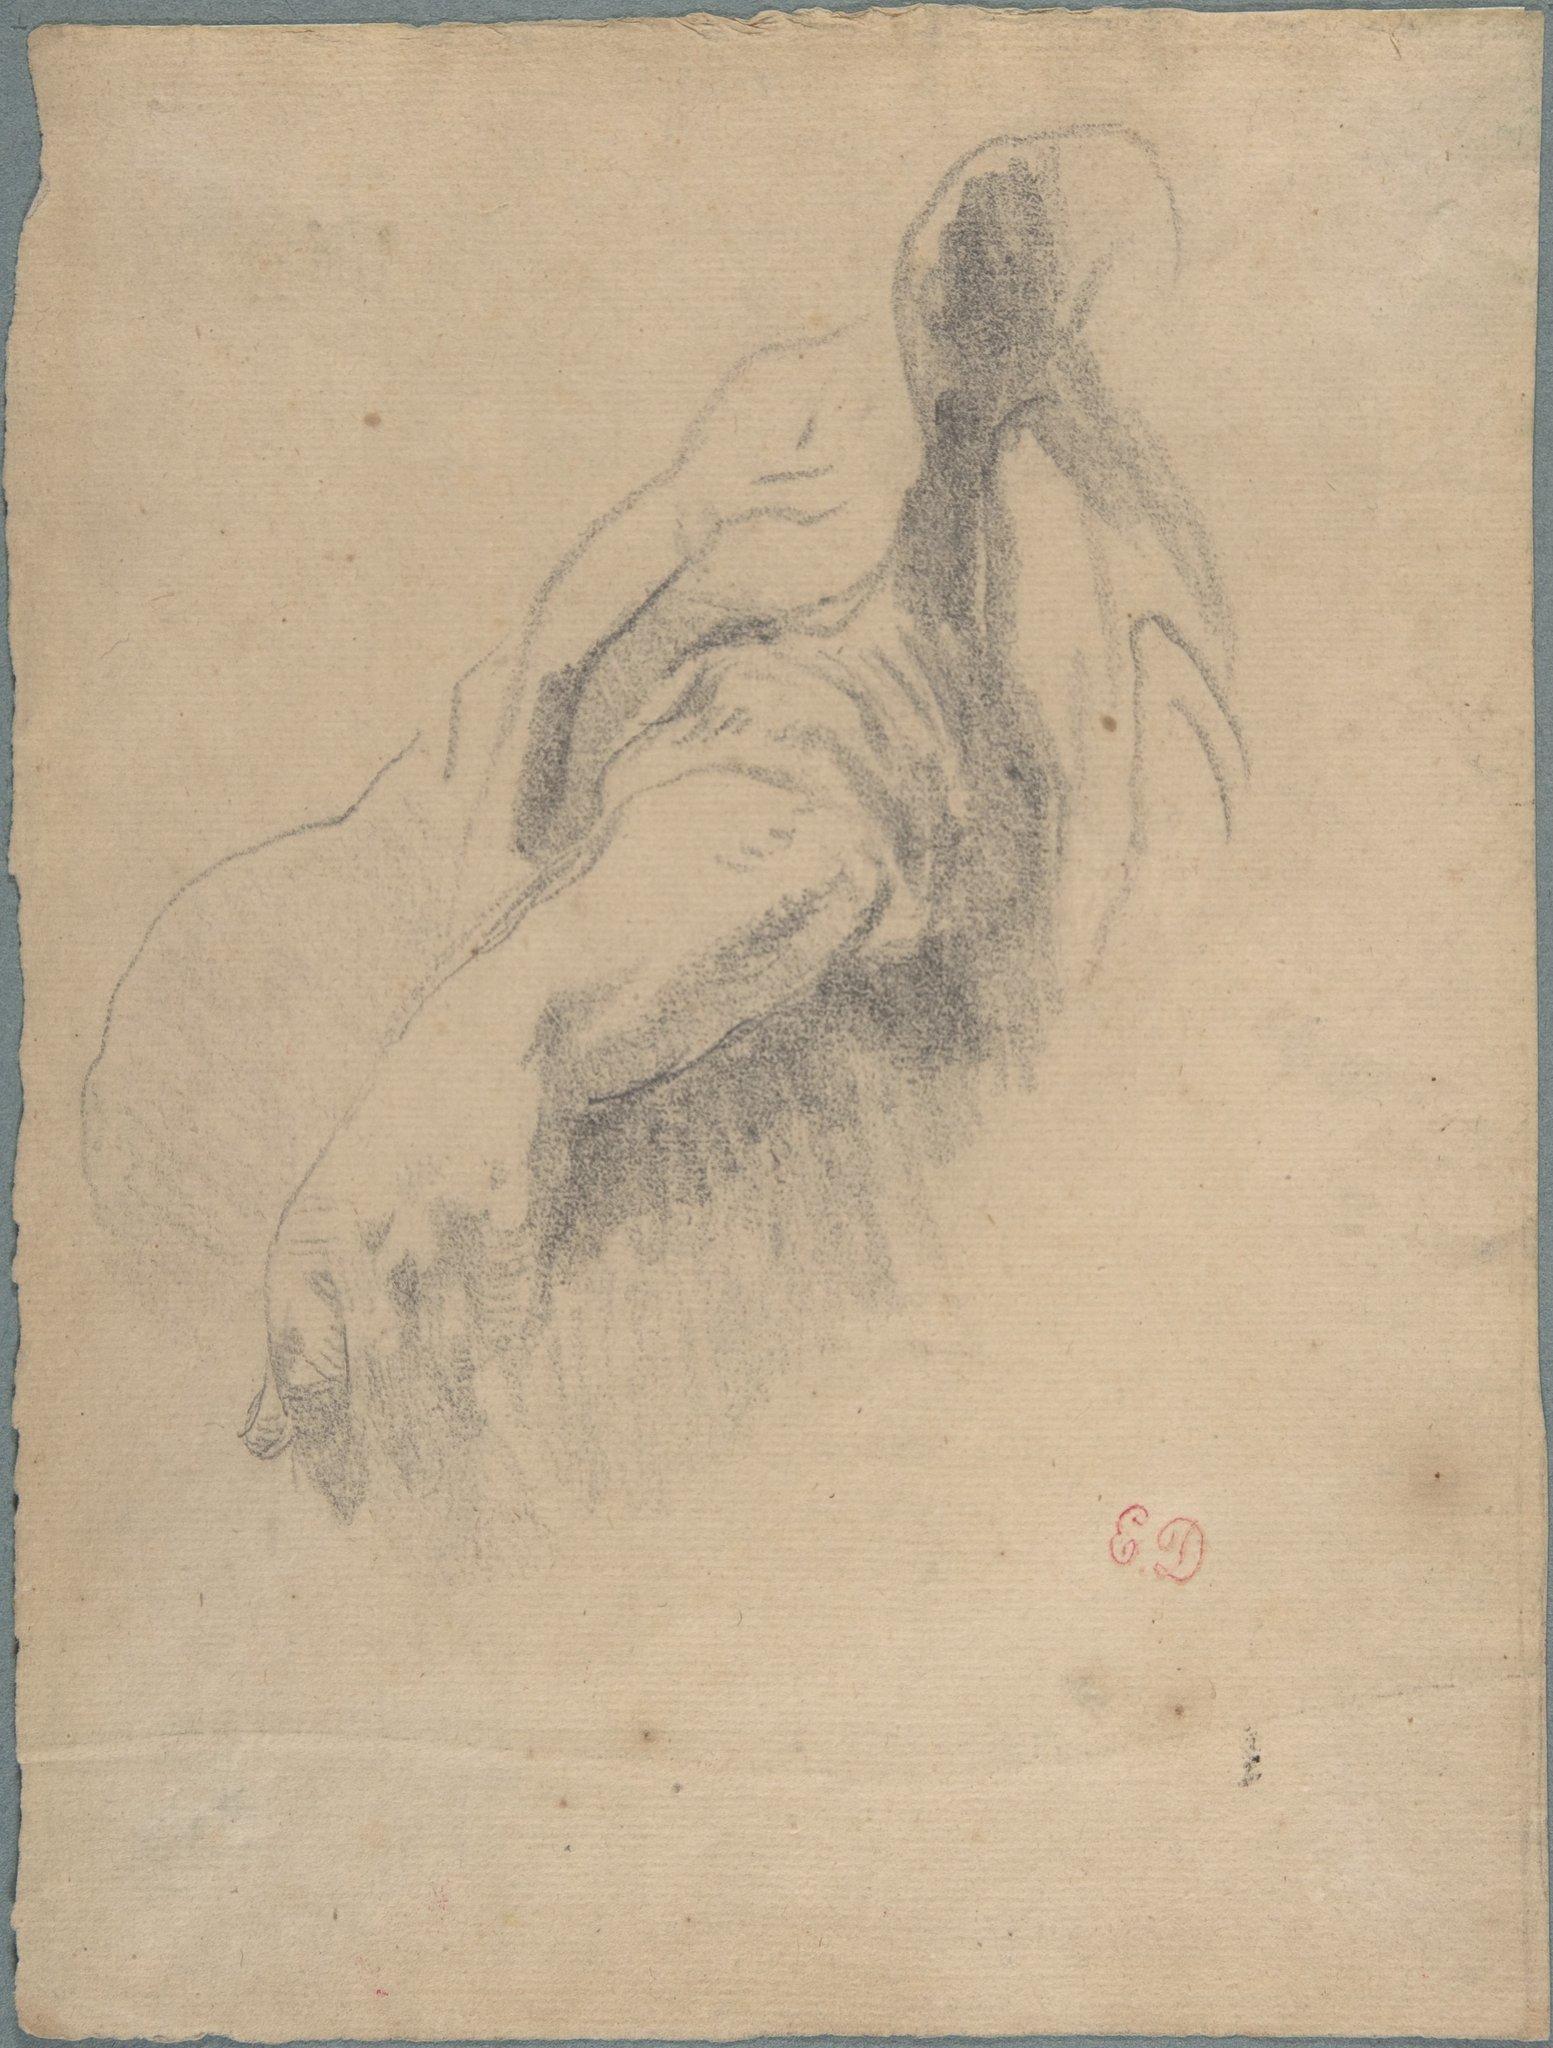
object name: drawing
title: Study of a Left Arm and Hand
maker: eugène delacroix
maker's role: artist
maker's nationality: french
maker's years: 1798-1863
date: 1815-1863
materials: graphite, paper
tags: hands